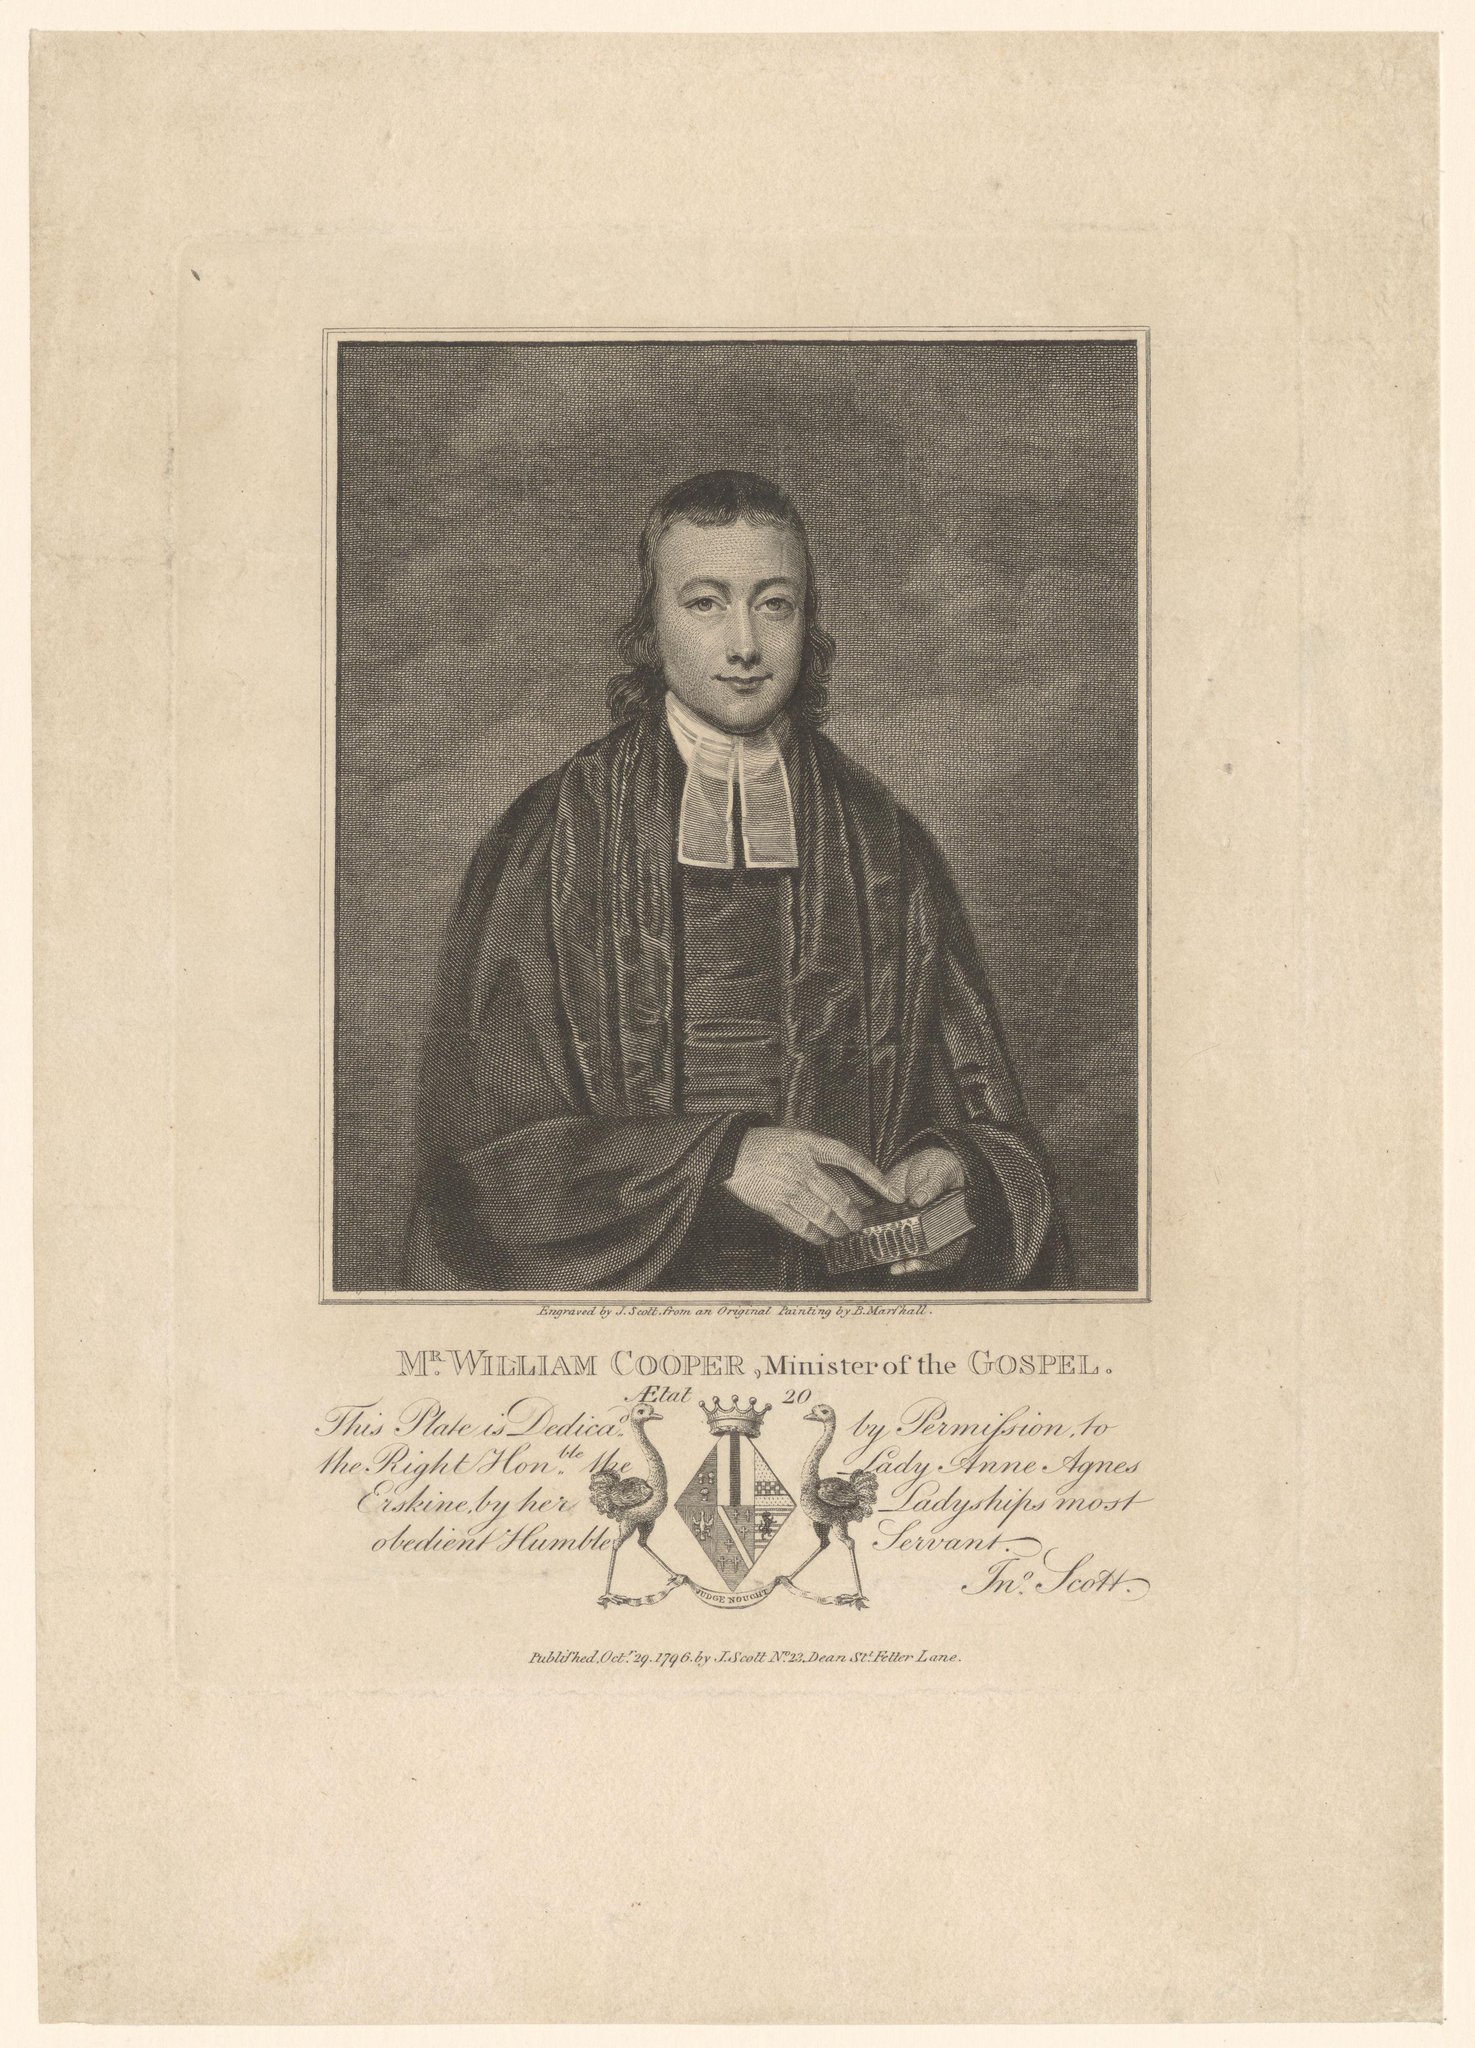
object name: print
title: Portret van William Cooper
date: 1796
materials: paper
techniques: engraving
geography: london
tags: priest, theologian, historical persons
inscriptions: collector's mark: Lugt 2228